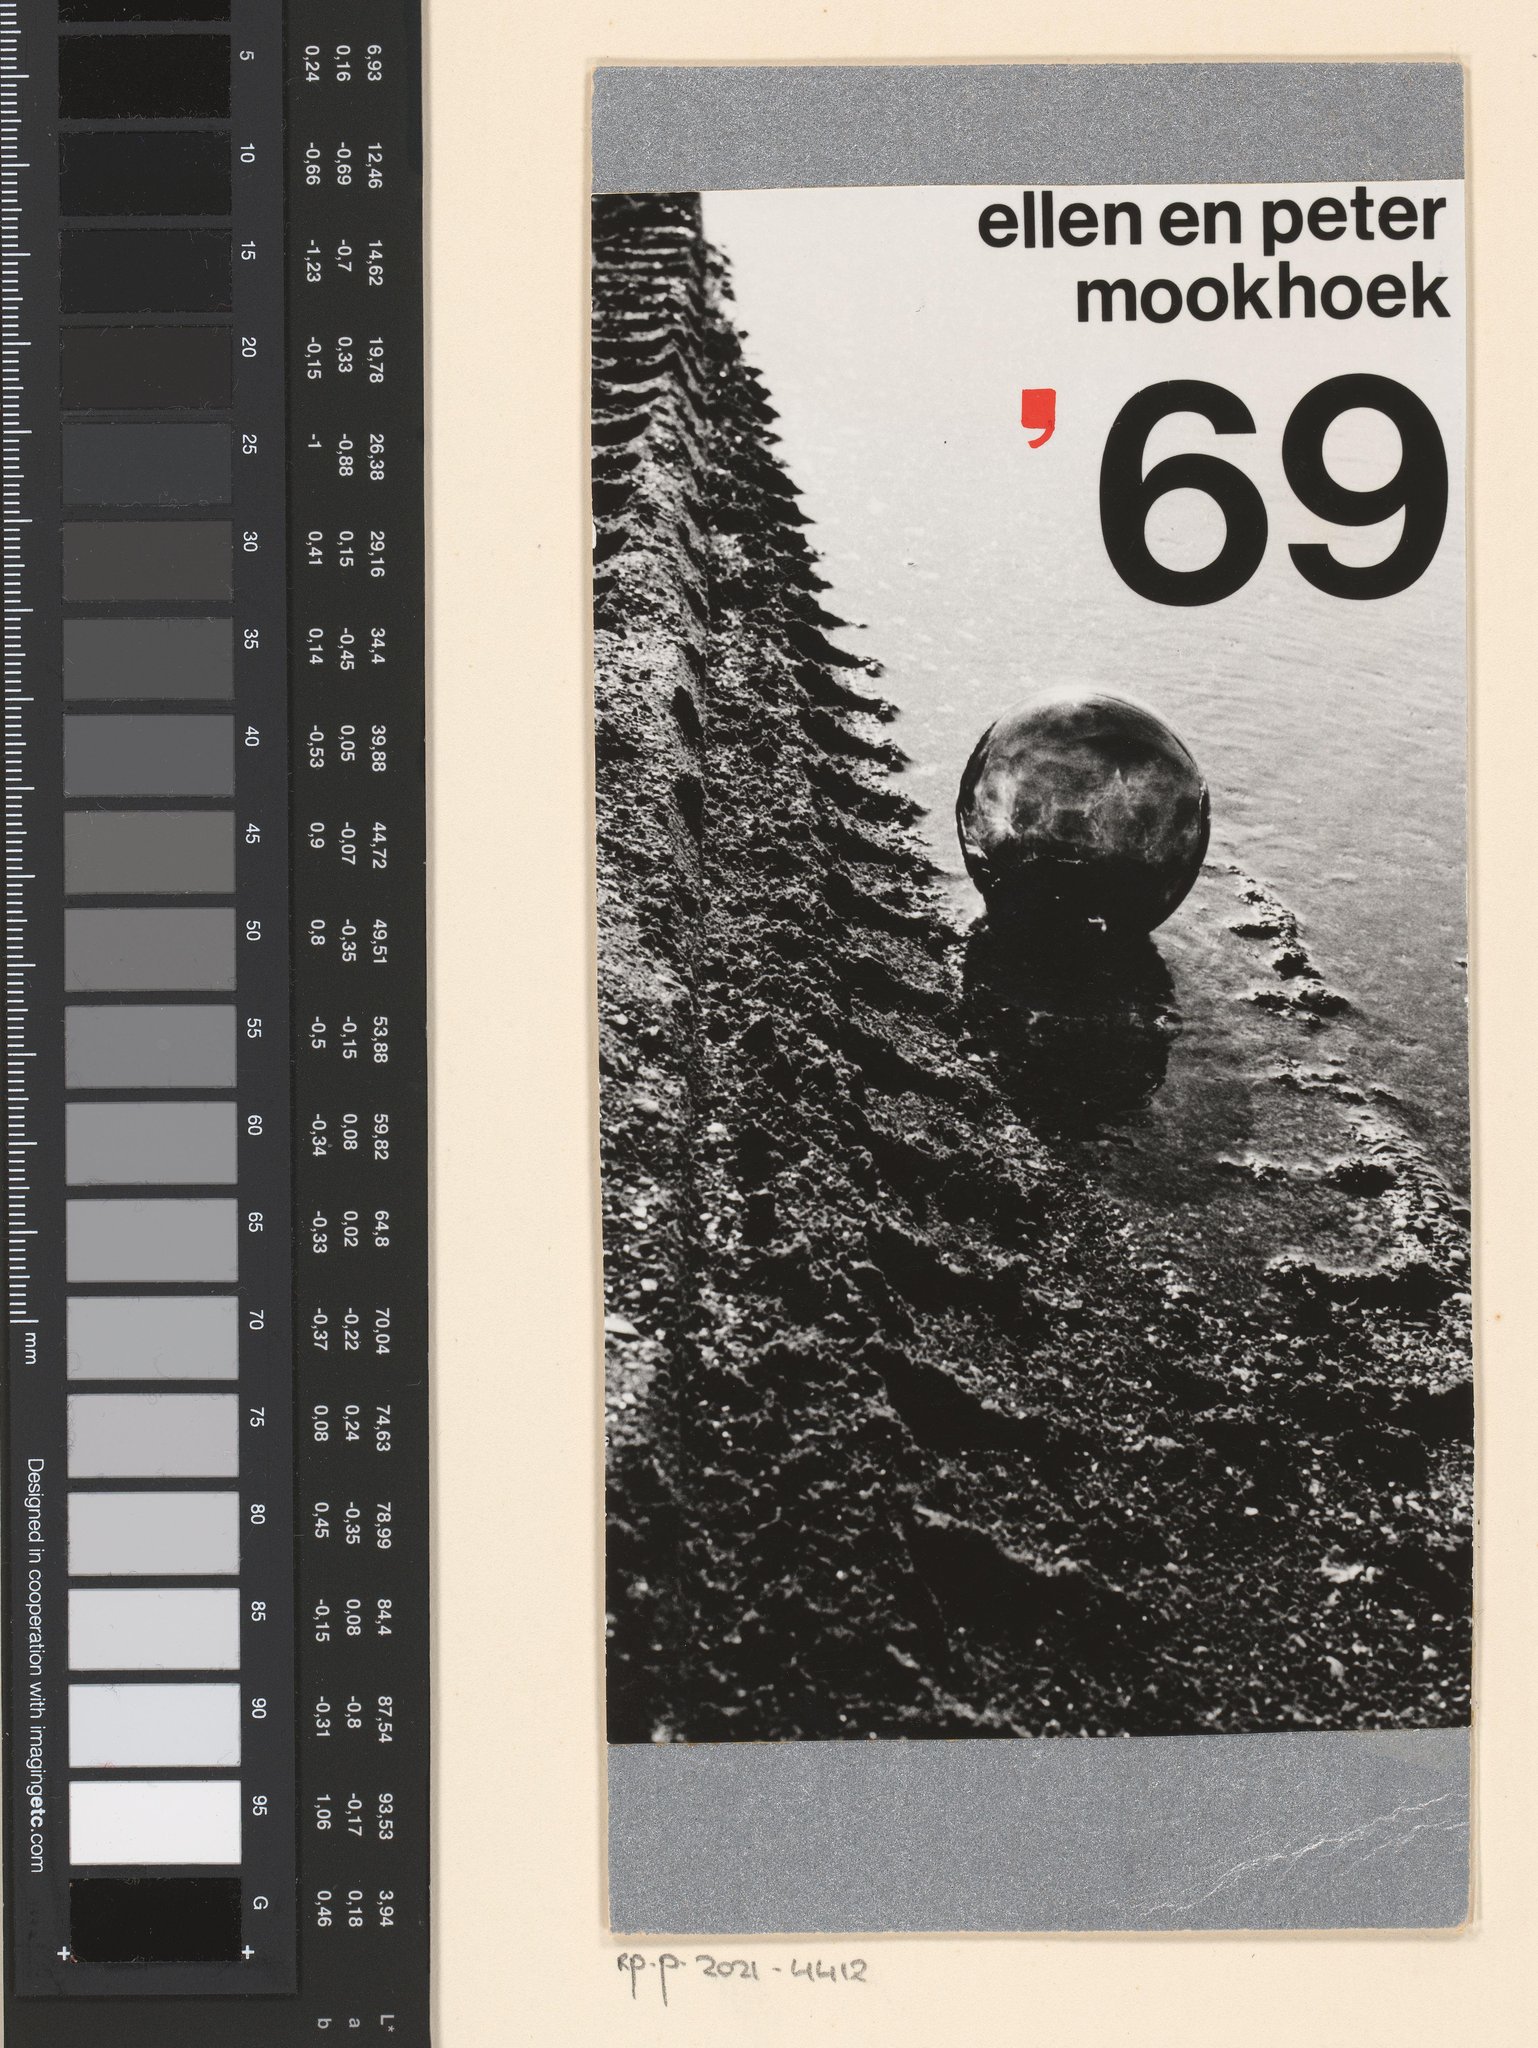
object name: new year card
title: Nieuwjaarswens voor 1969 van Ellen en Peter Mookhoek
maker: Anonymous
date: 1968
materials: cardboard, paper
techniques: photography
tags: river bank